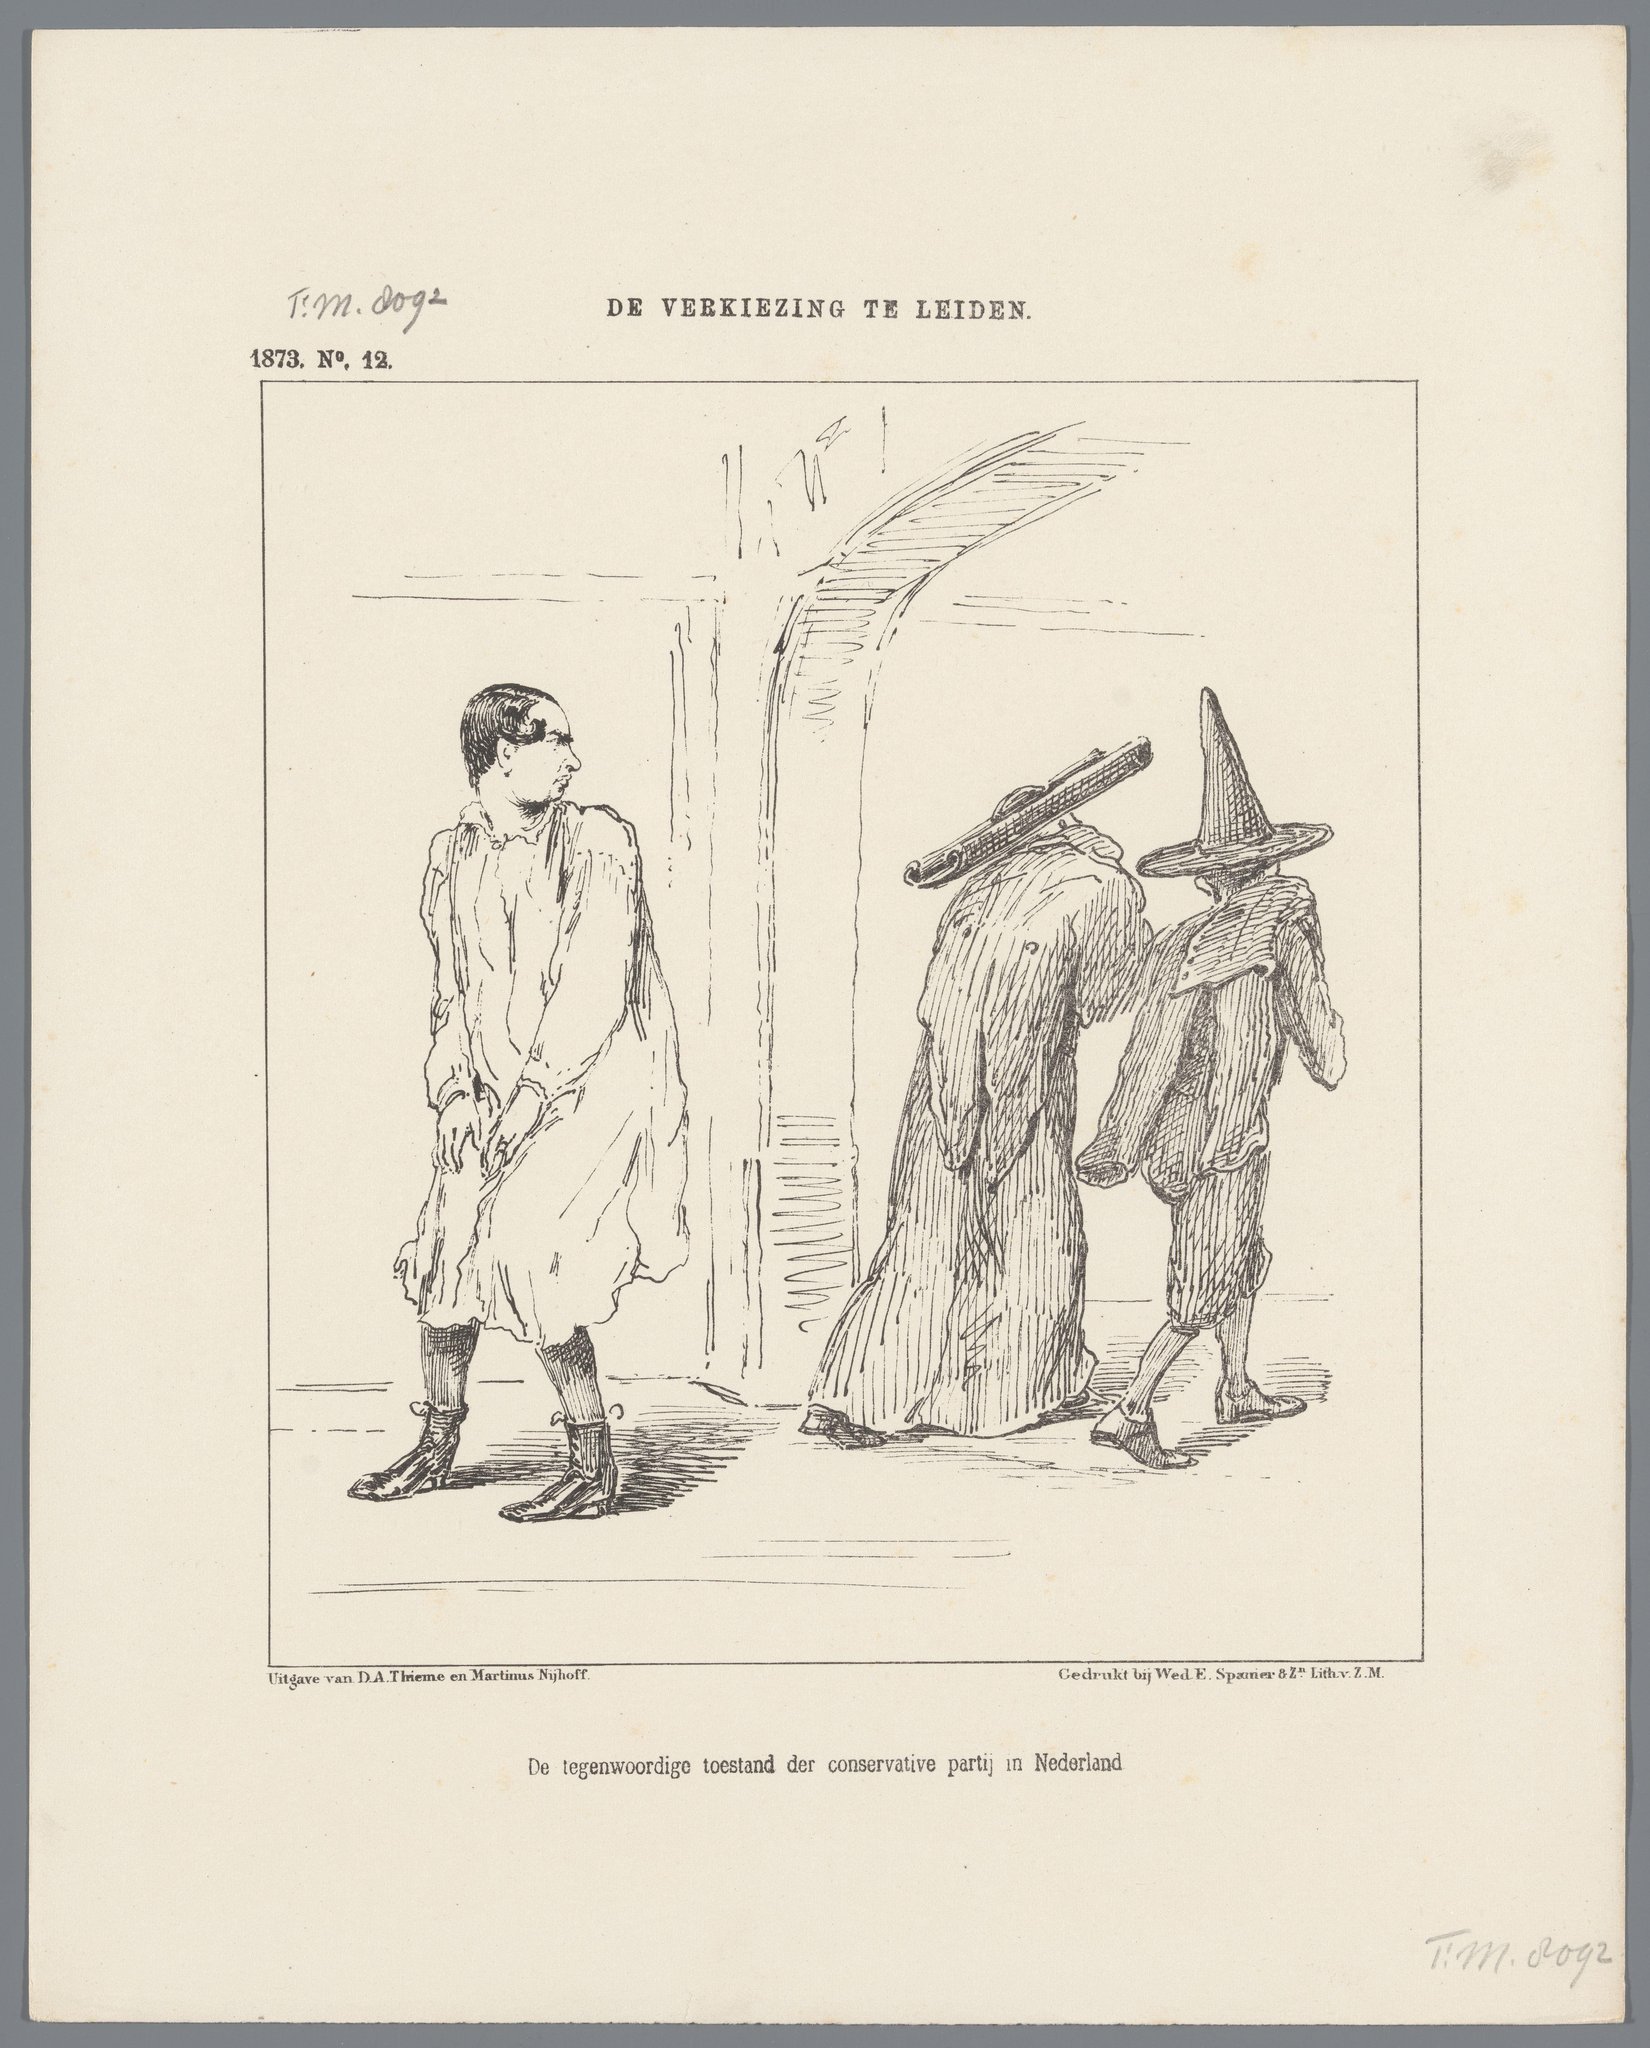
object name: print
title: Spotprent over de toestand van de conservatieve partij te Leiden, 1873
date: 1873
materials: paper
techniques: lithograph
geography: the hague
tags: amsterdam, the hague, rutger jan graaf schimmelpenninck van nyenhuis, leiden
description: Spotprent over de toestand van de conservatieve partij te Leiden. Links staat Rutger Jan Graaf Schimmelpenninck in zijn hemd, een jezuïet en een antirevolutionnair lopen met zijn kleren weg. Plaat verschenen bij het weekblad De Nederlandsche Spectator, nr. 12, 1873.